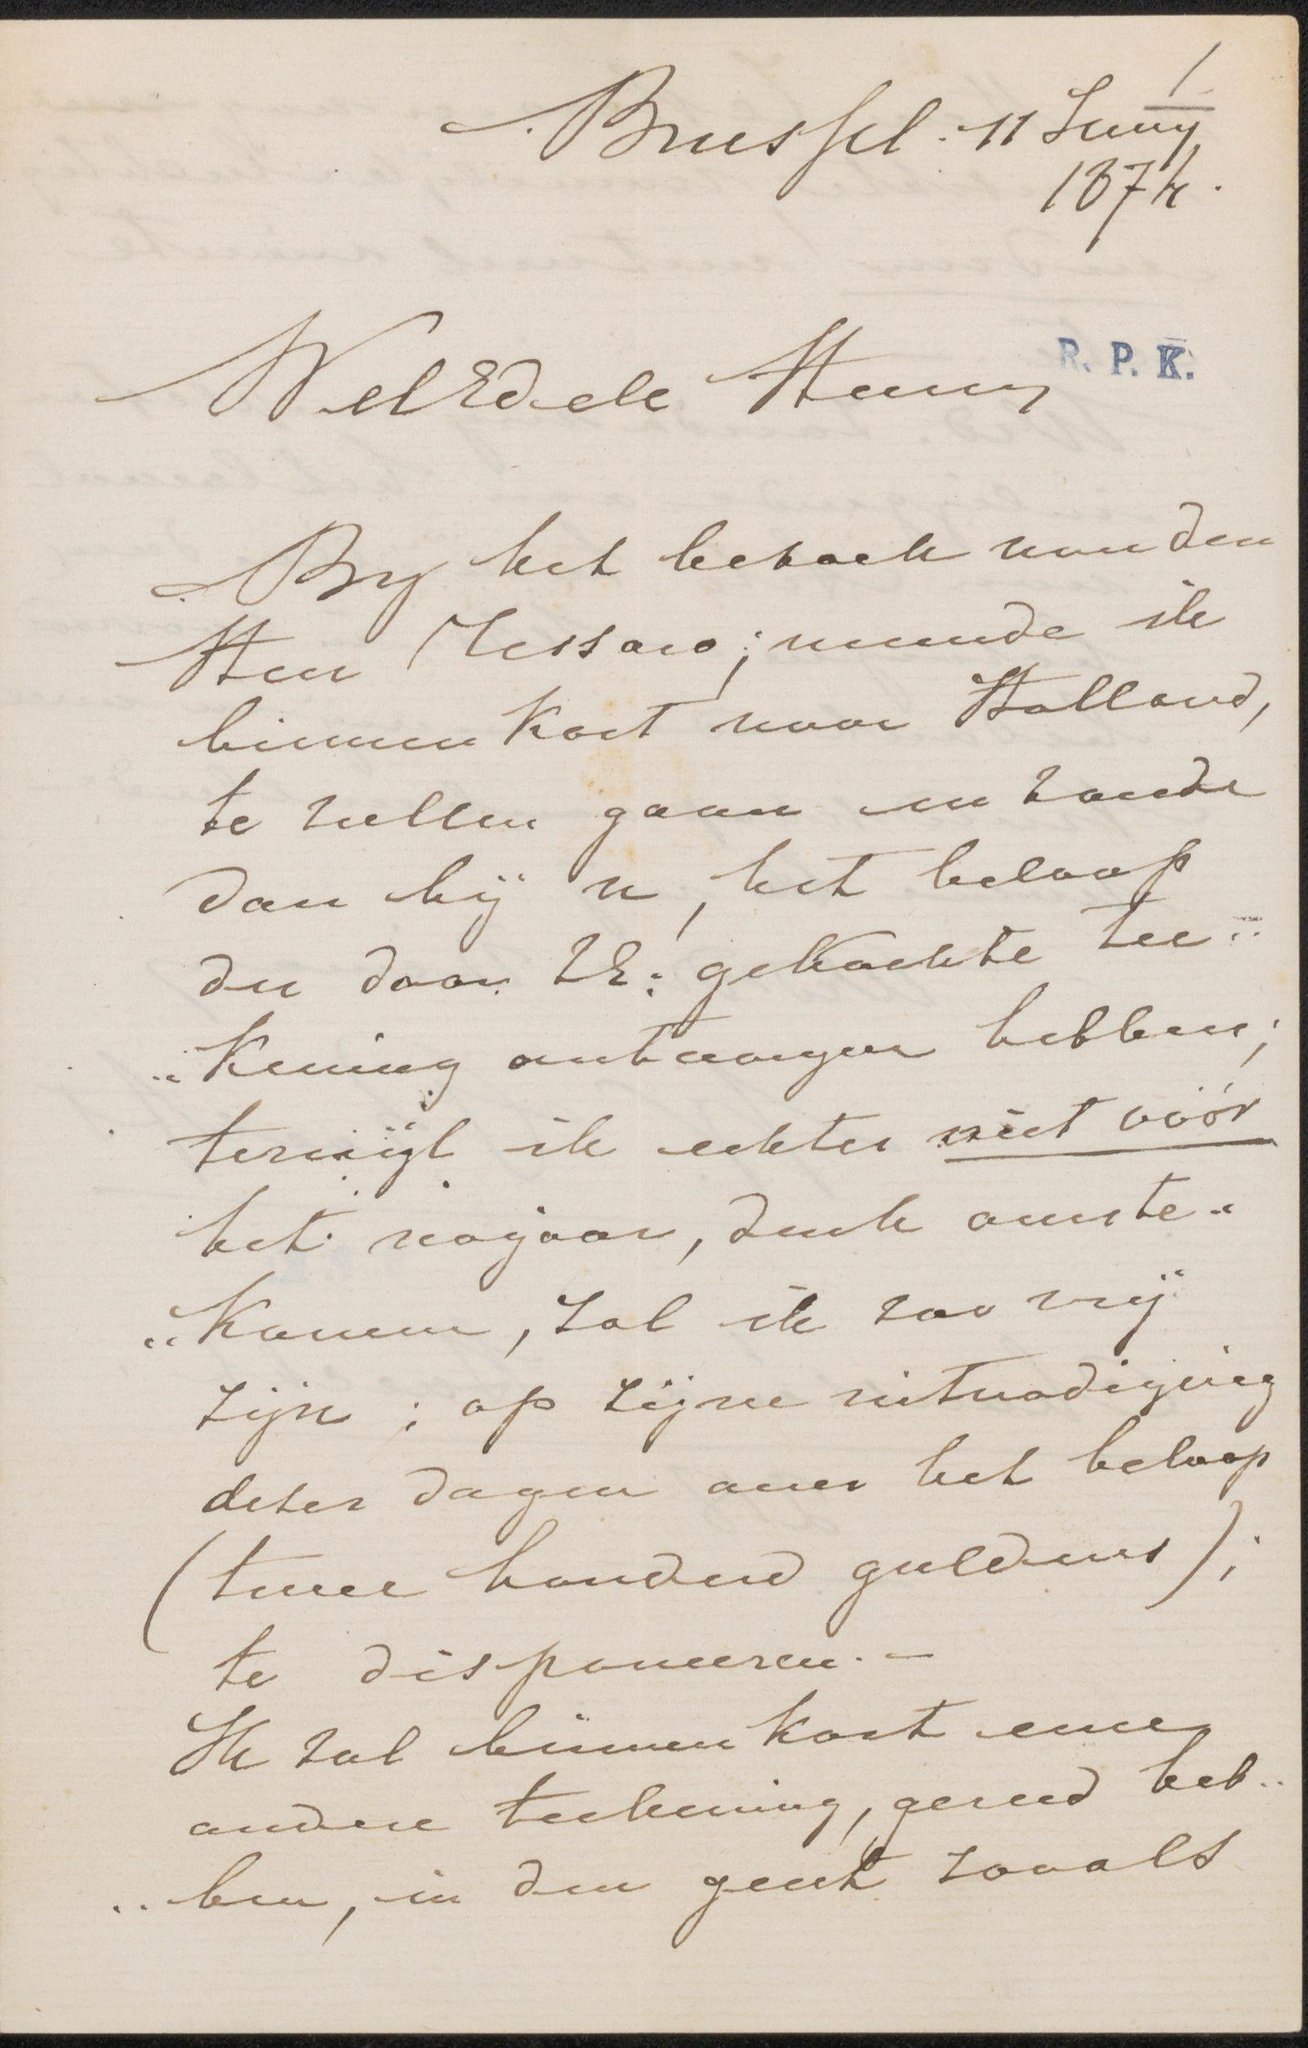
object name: letter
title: Brief aan Frans Buffa en Zonen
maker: willem roelofs (i)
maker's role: draughtsman, painter, print maker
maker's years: 1822-1897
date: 1874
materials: ink, paper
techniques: pen, writing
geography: brussels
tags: painter, print maker, draughtsman, hendrik willem mesdag, publisher, art trade, art shop, drawing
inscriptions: collector's mark: Lugt 2233